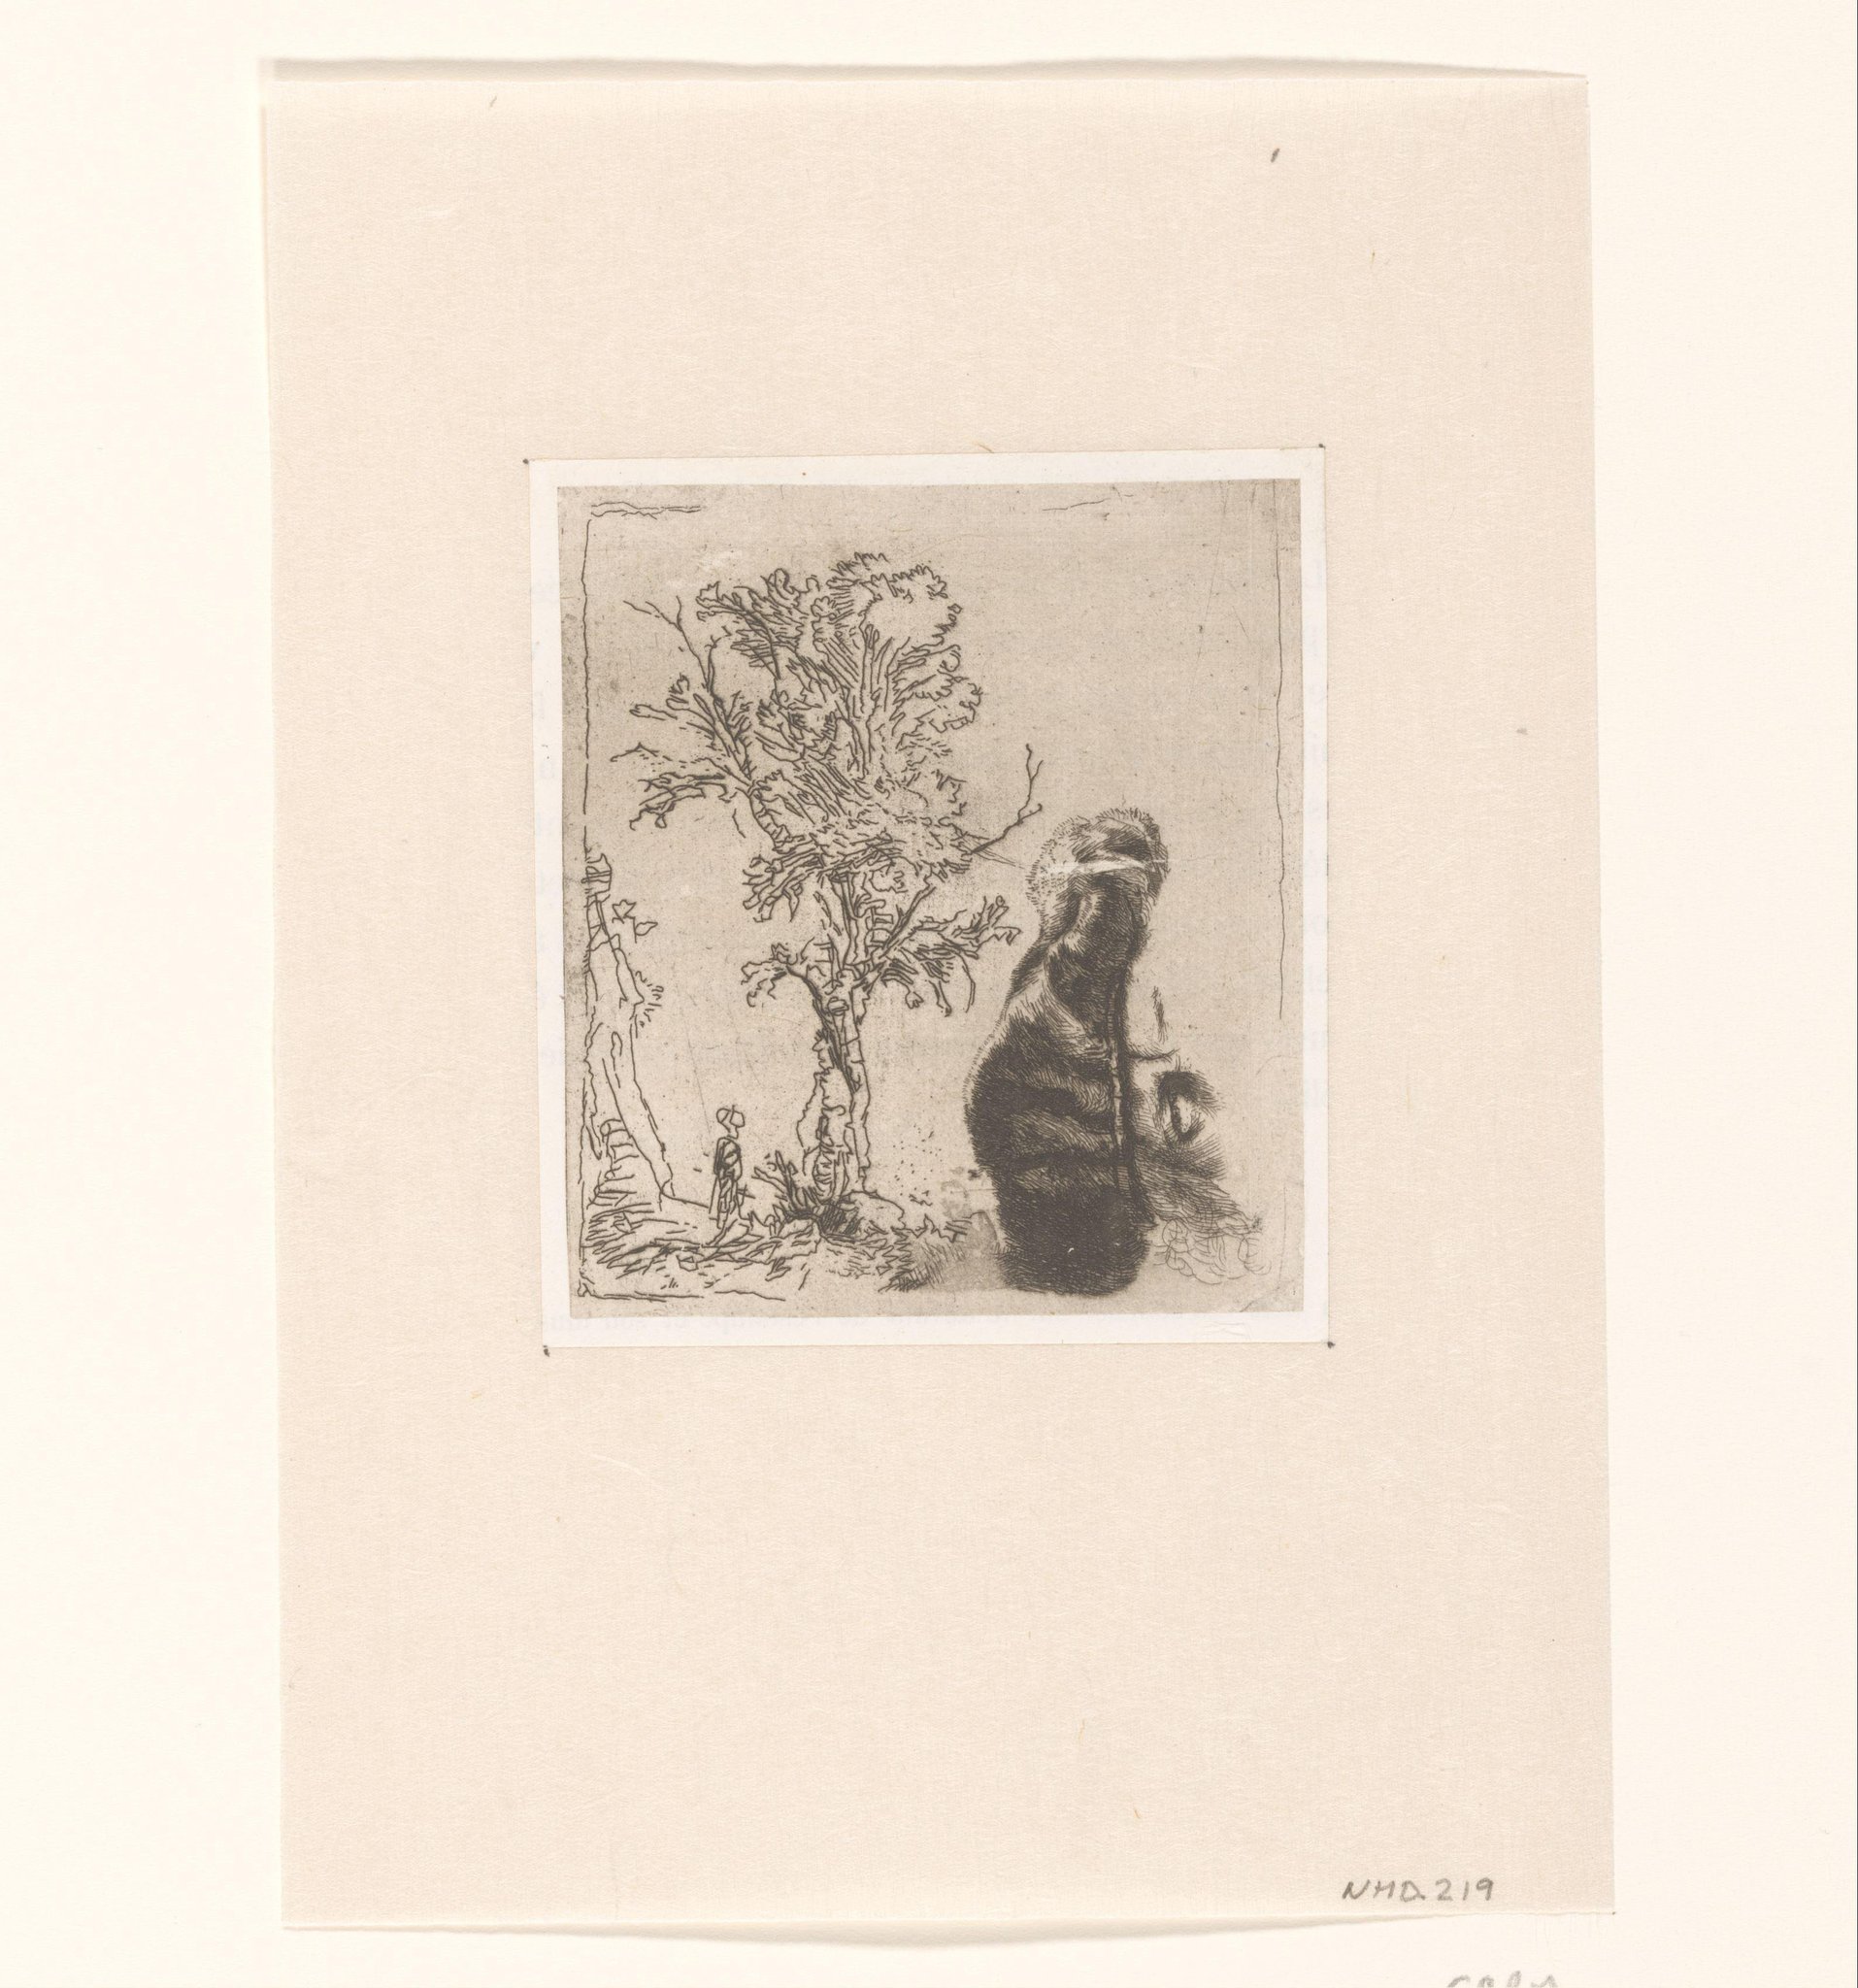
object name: print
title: Sheet with two studies: a tree, and the upper part of the head of the artist wearing a velvet cap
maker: léopold flameng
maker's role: print maker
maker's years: 1831-1911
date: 1859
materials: paper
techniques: etching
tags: leiden, painter, draughtsman, rembrandt van rijn, drawing, sketch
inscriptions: collector's mark: Lugt 2760, collector's mark: Lugt 2228